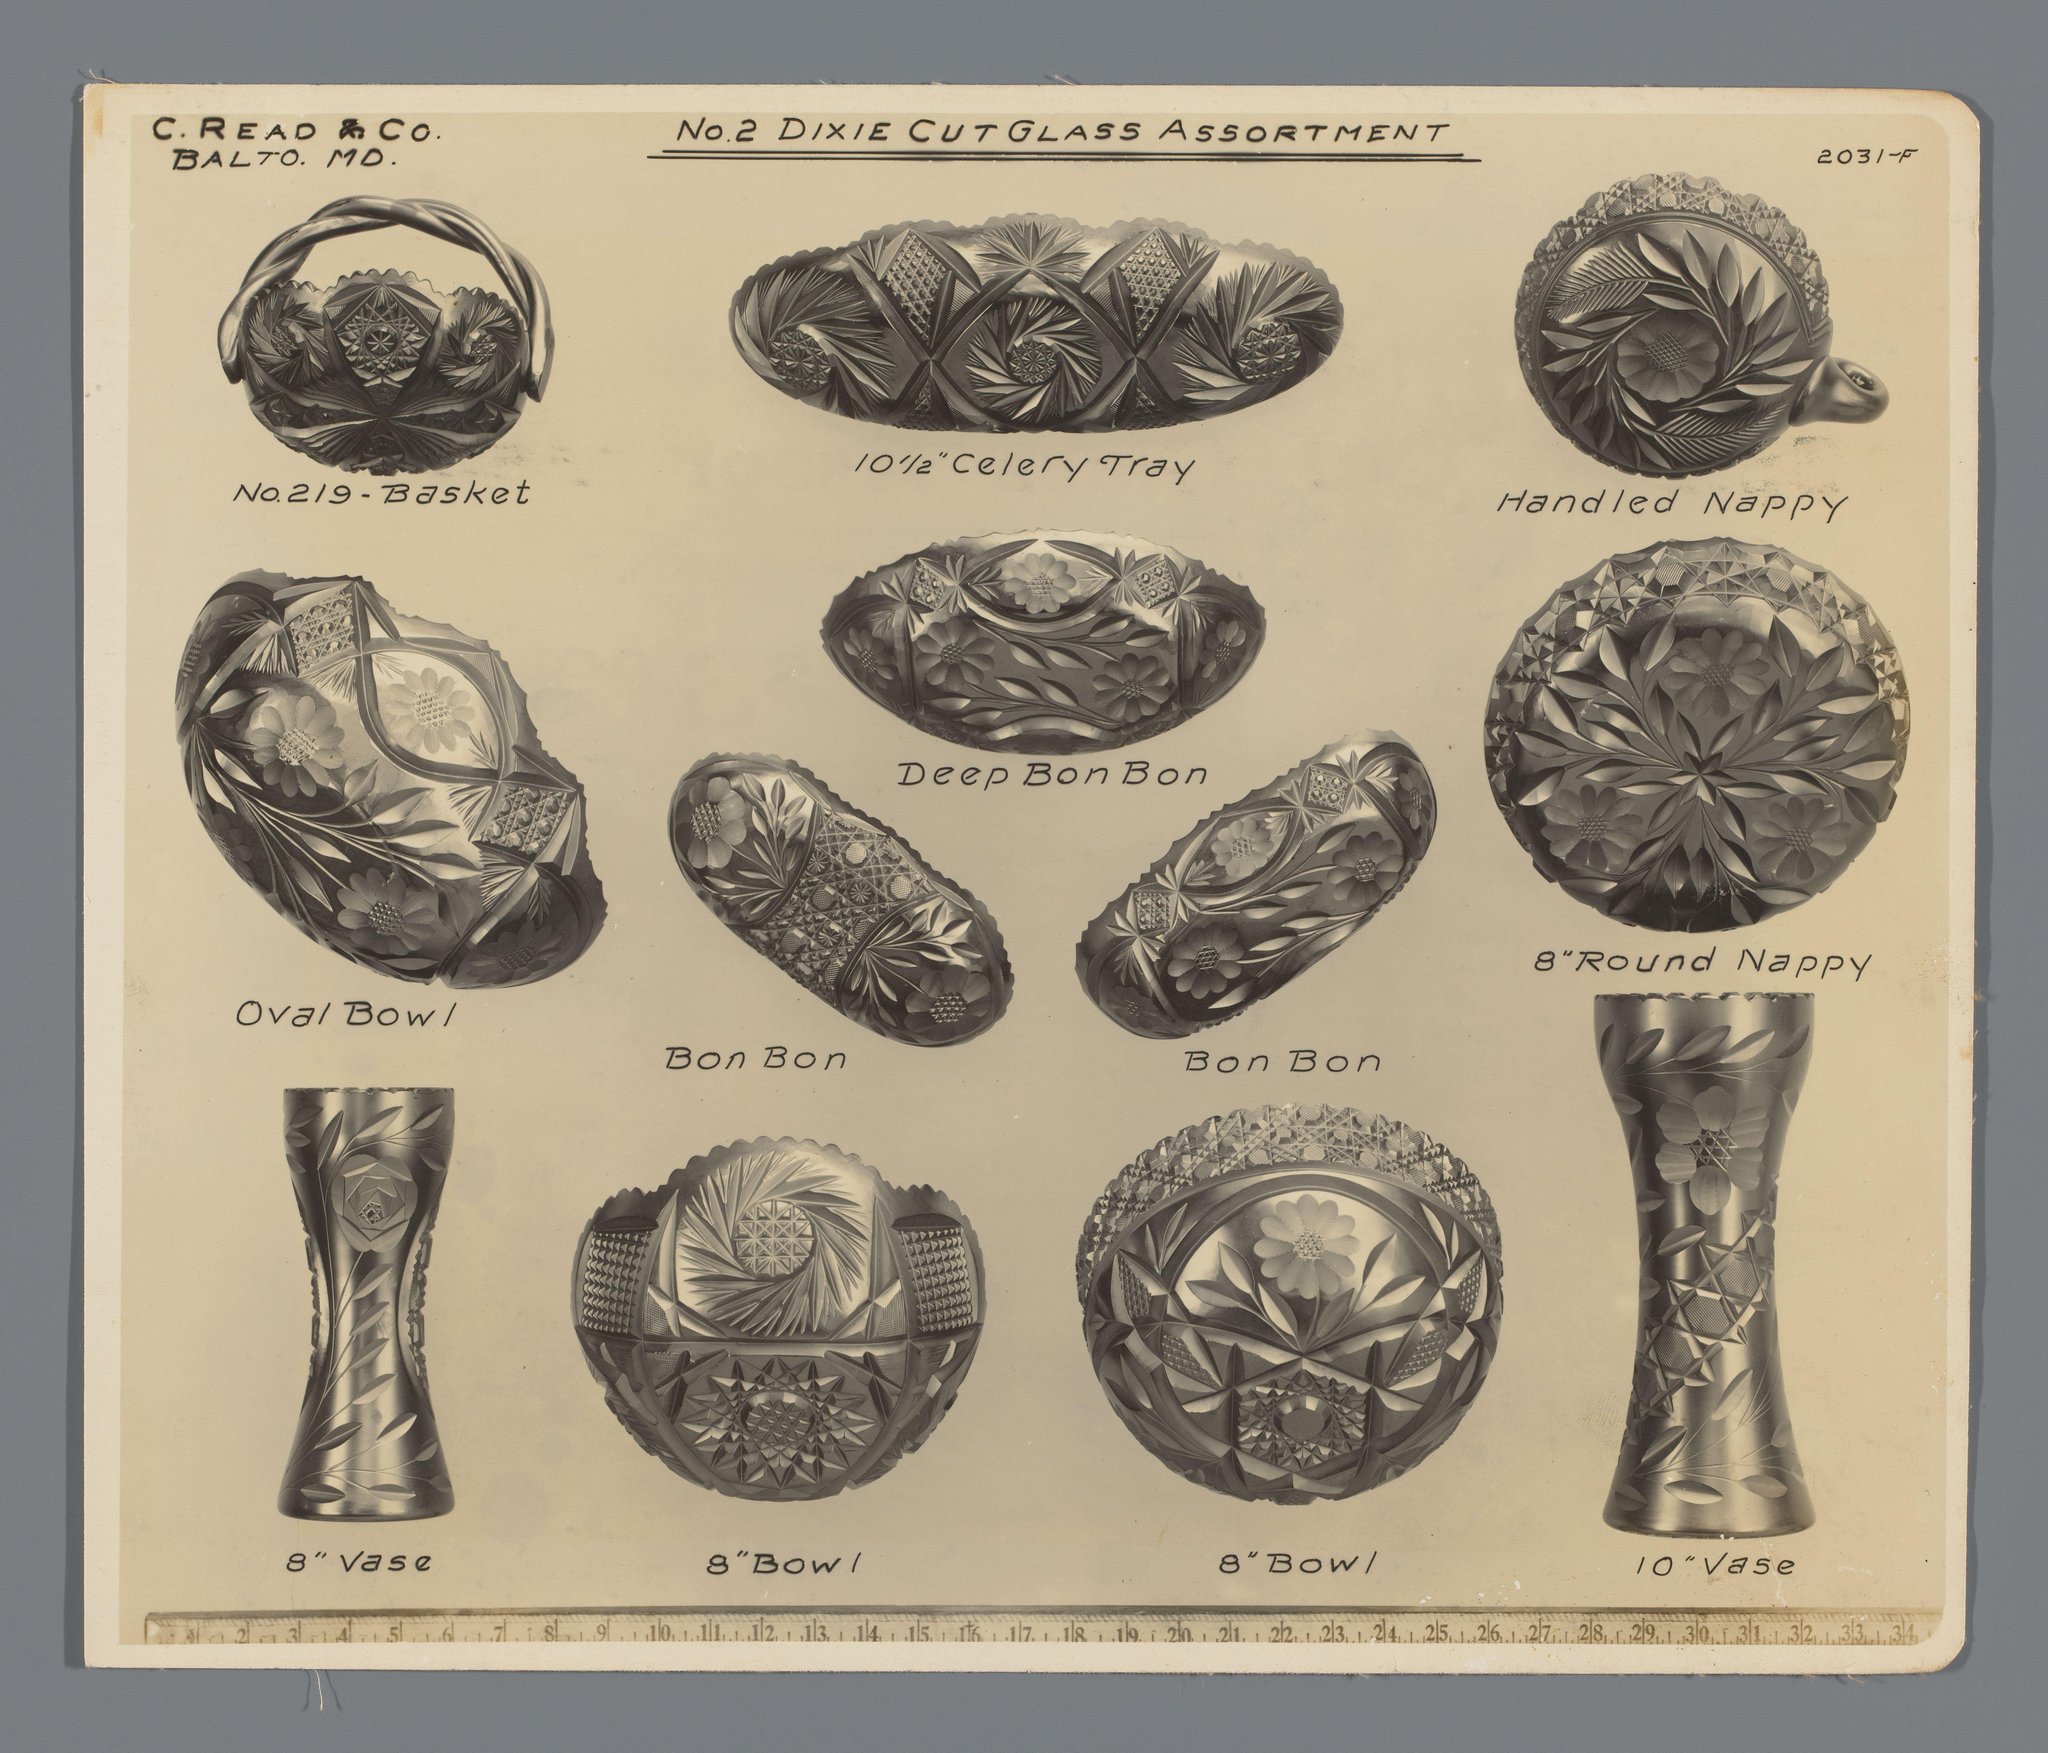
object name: photograph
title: Reclamefoto met serviezen en keukengerei van de firma C. Read & Co., Baltimore, Maryland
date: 1920-1930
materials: paper, textile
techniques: photography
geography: united states